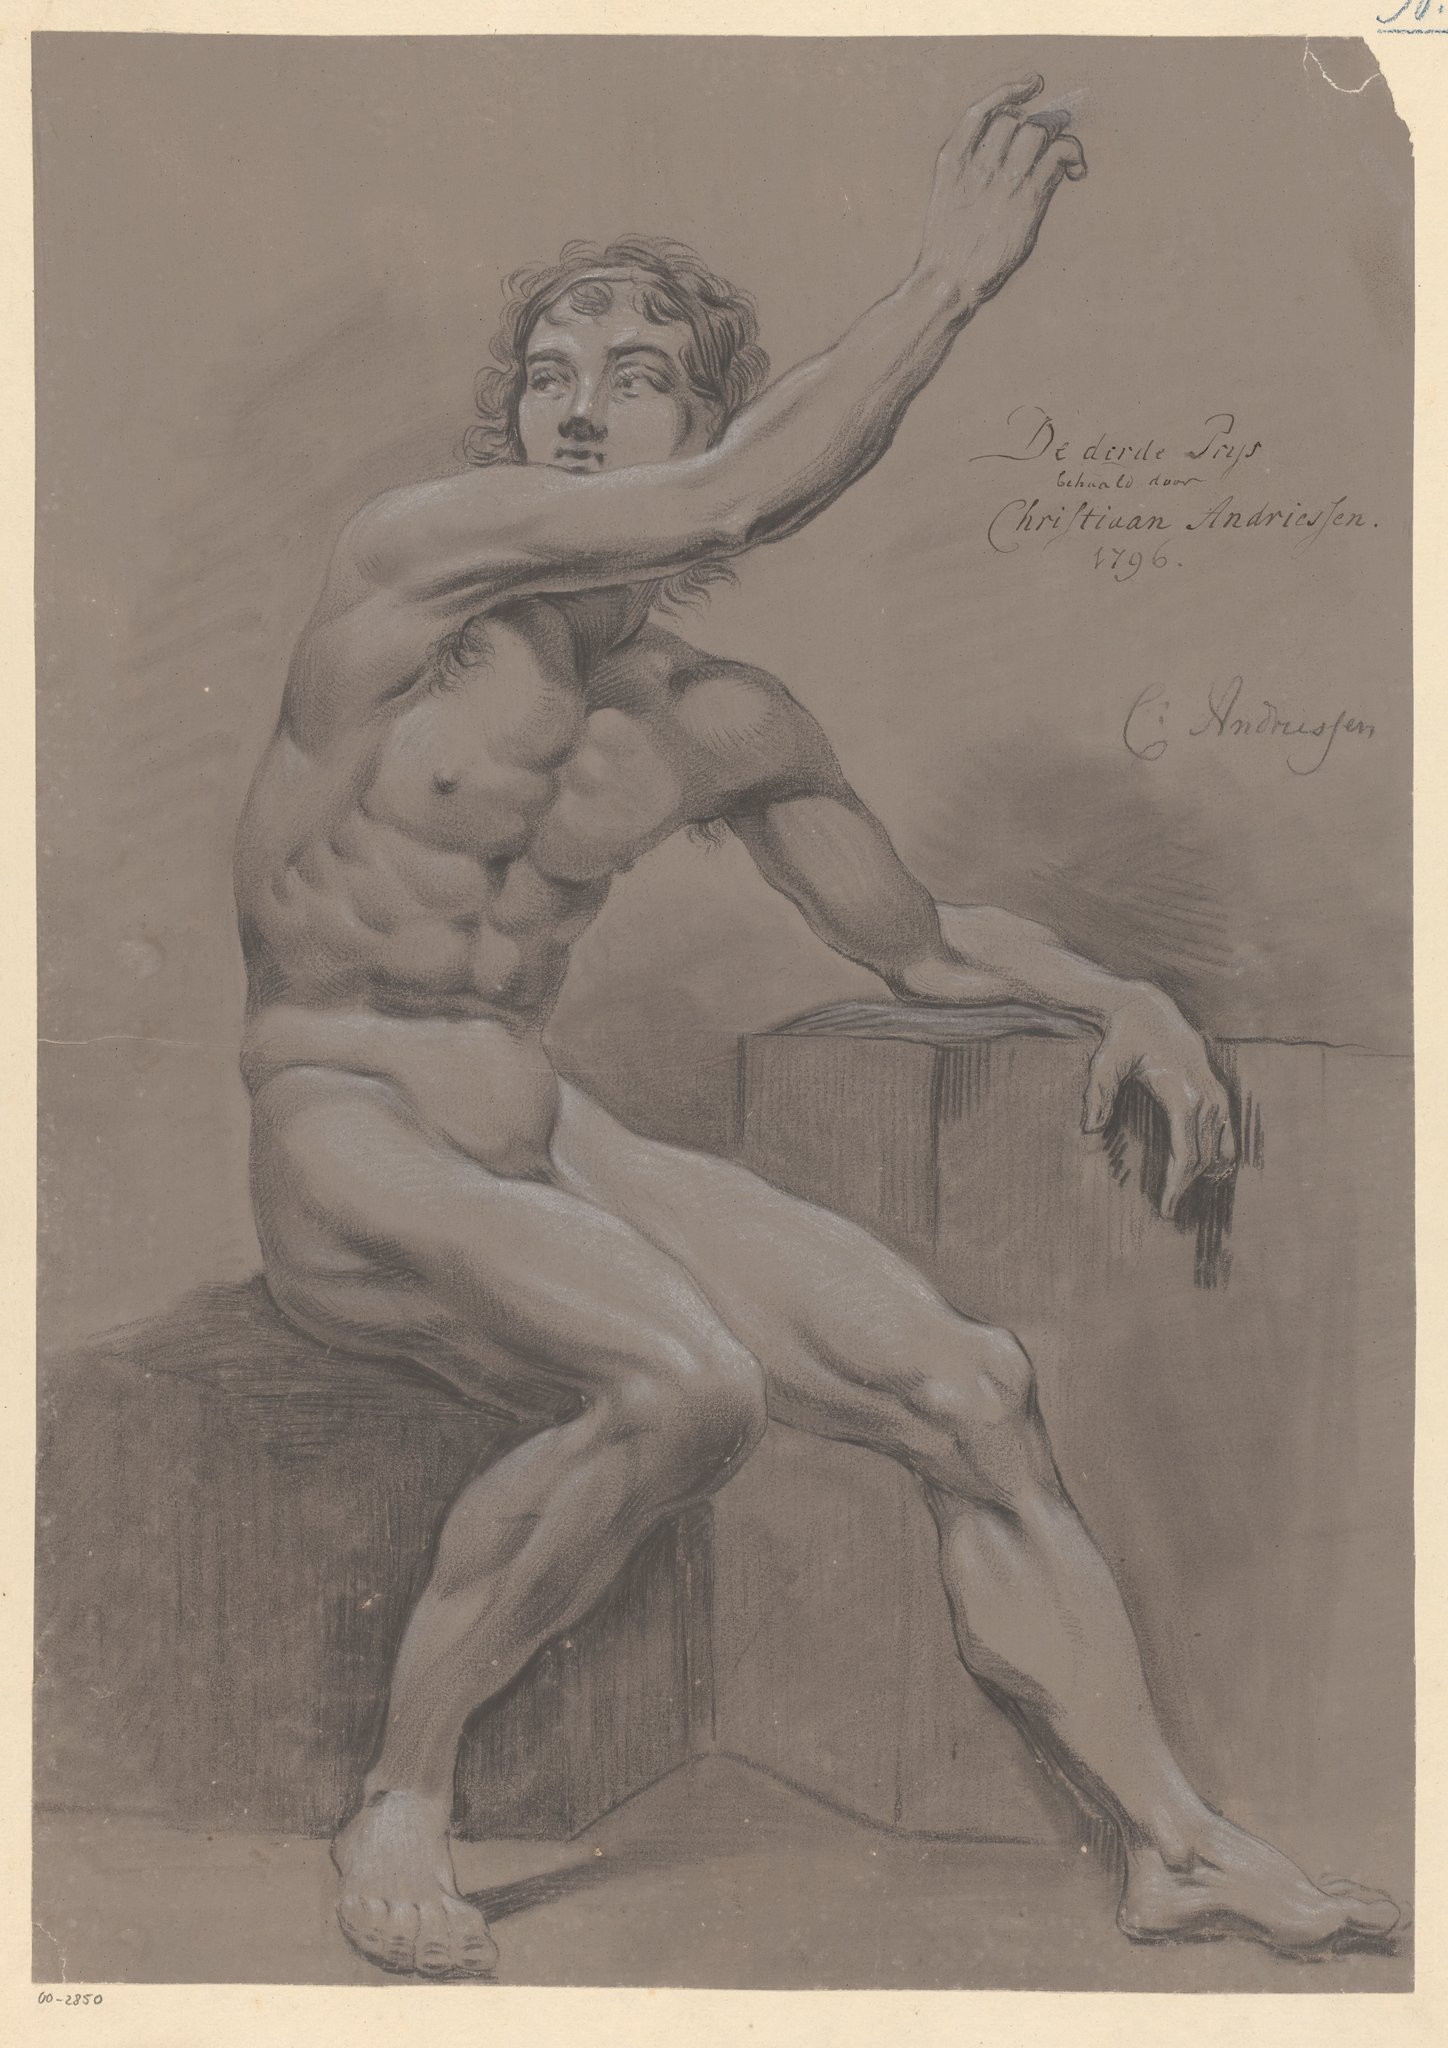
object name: drawing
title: Zittend mannelijk naakt, van opzij gezien (3e prijs 1796)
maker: christiaan andriessen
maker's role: draughtsman, print maker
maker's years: 1775-1846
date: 1796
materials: chalk, paper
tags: sitting figure (+ nude human being)